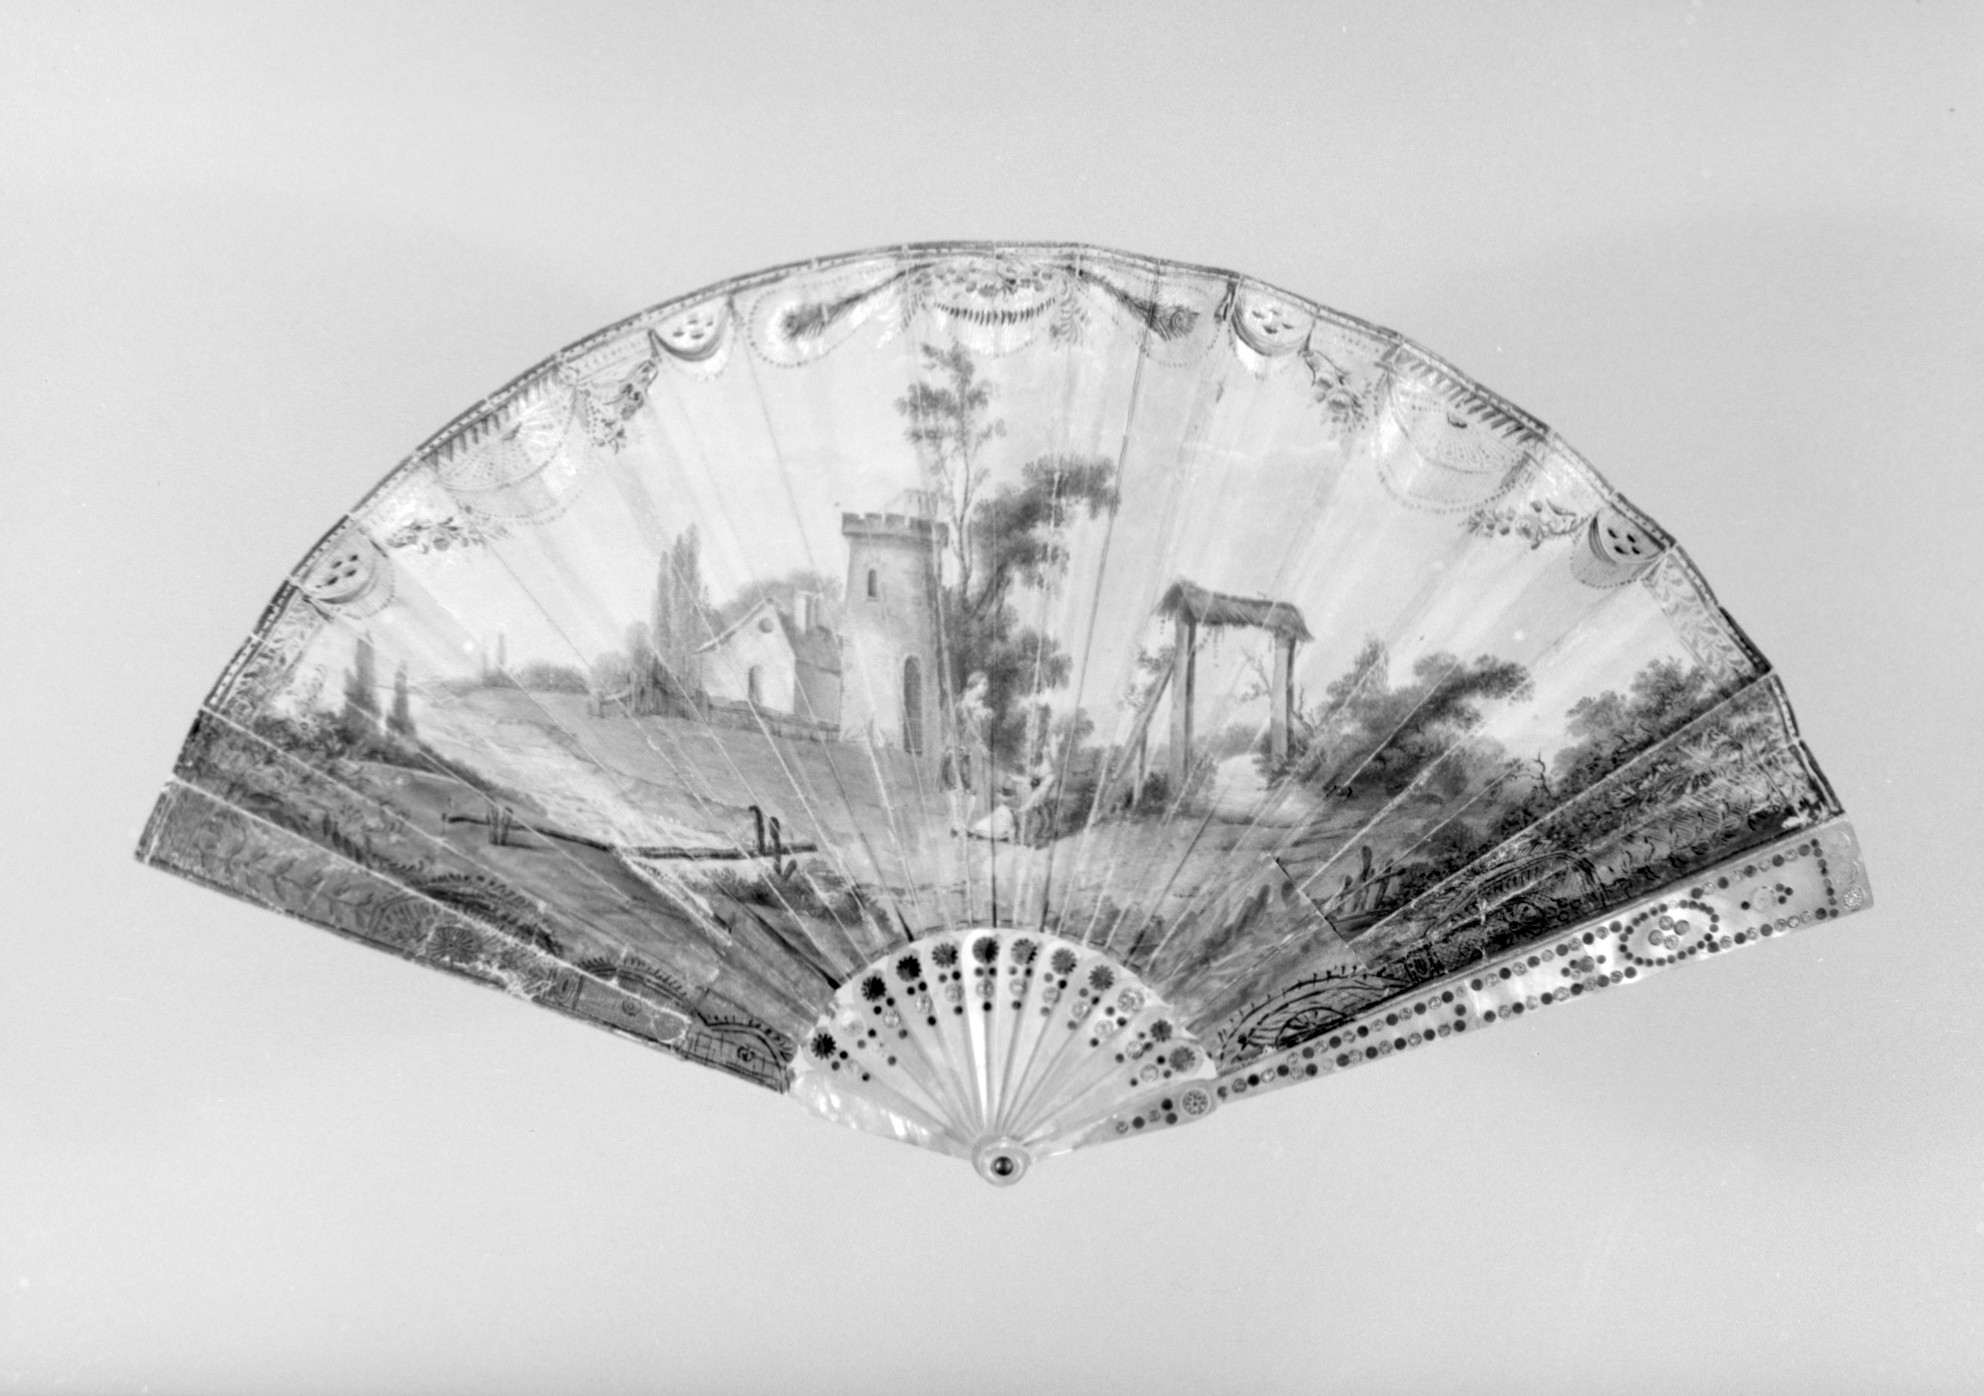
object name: fan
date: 1801-1833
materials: gilt, gold, metal, mother of pearl, paint, paper, parchment, silver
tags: men,women